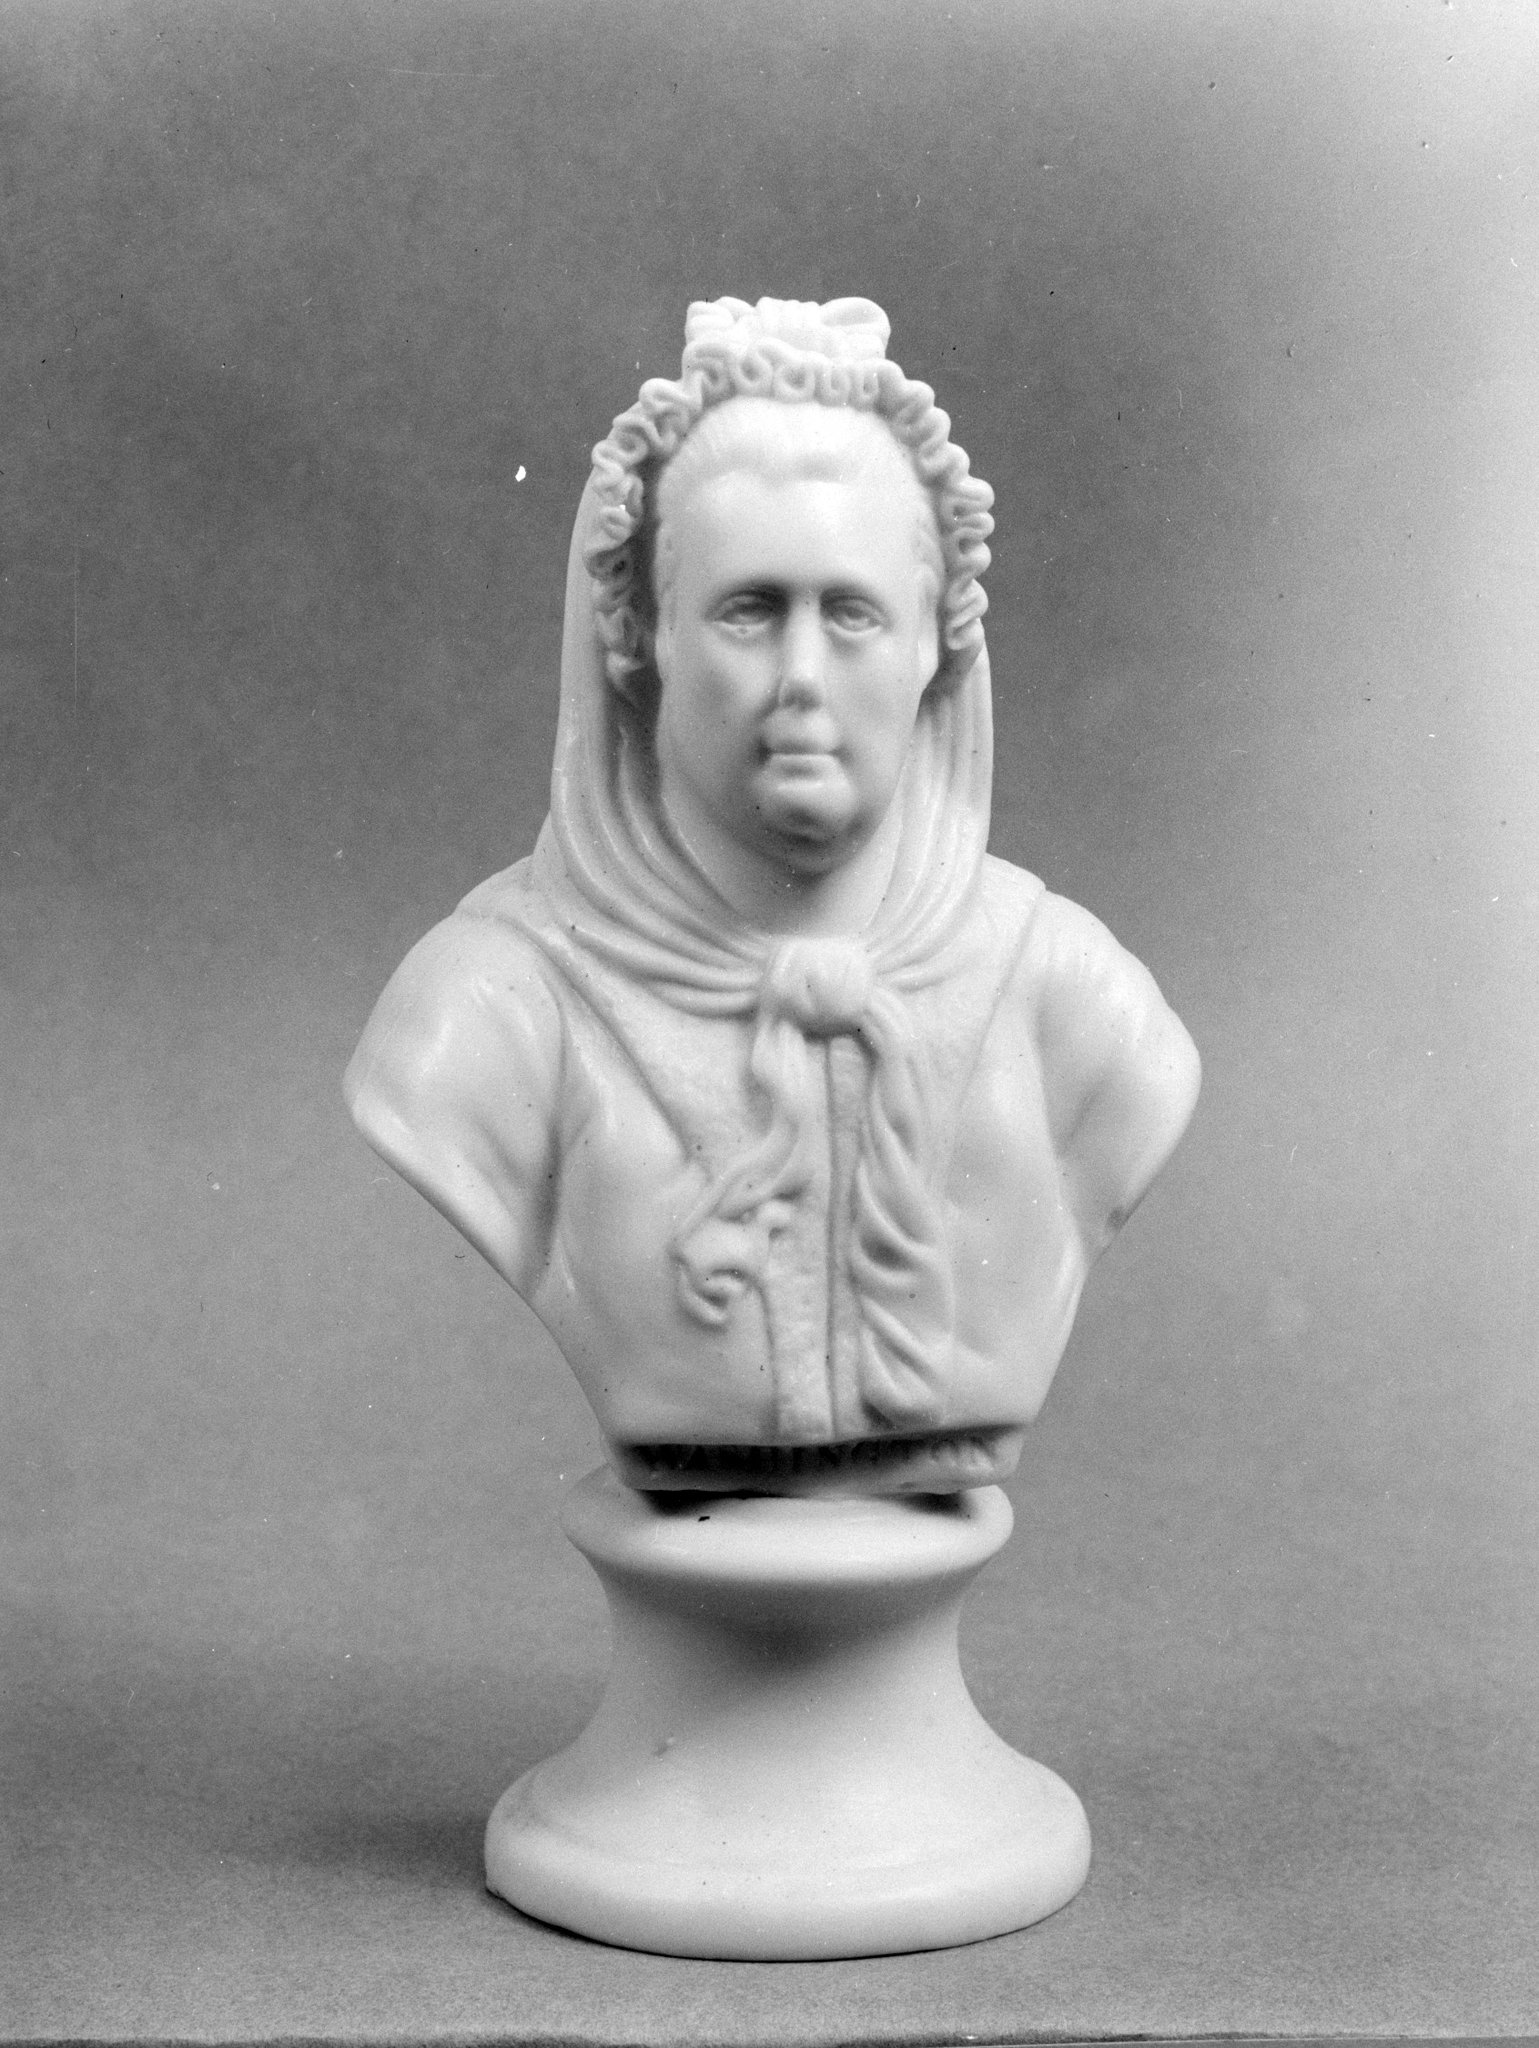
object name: bust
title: Bust of Mary Washington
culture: american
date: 1830-1870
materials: porcelain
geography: united states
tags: portraits,women